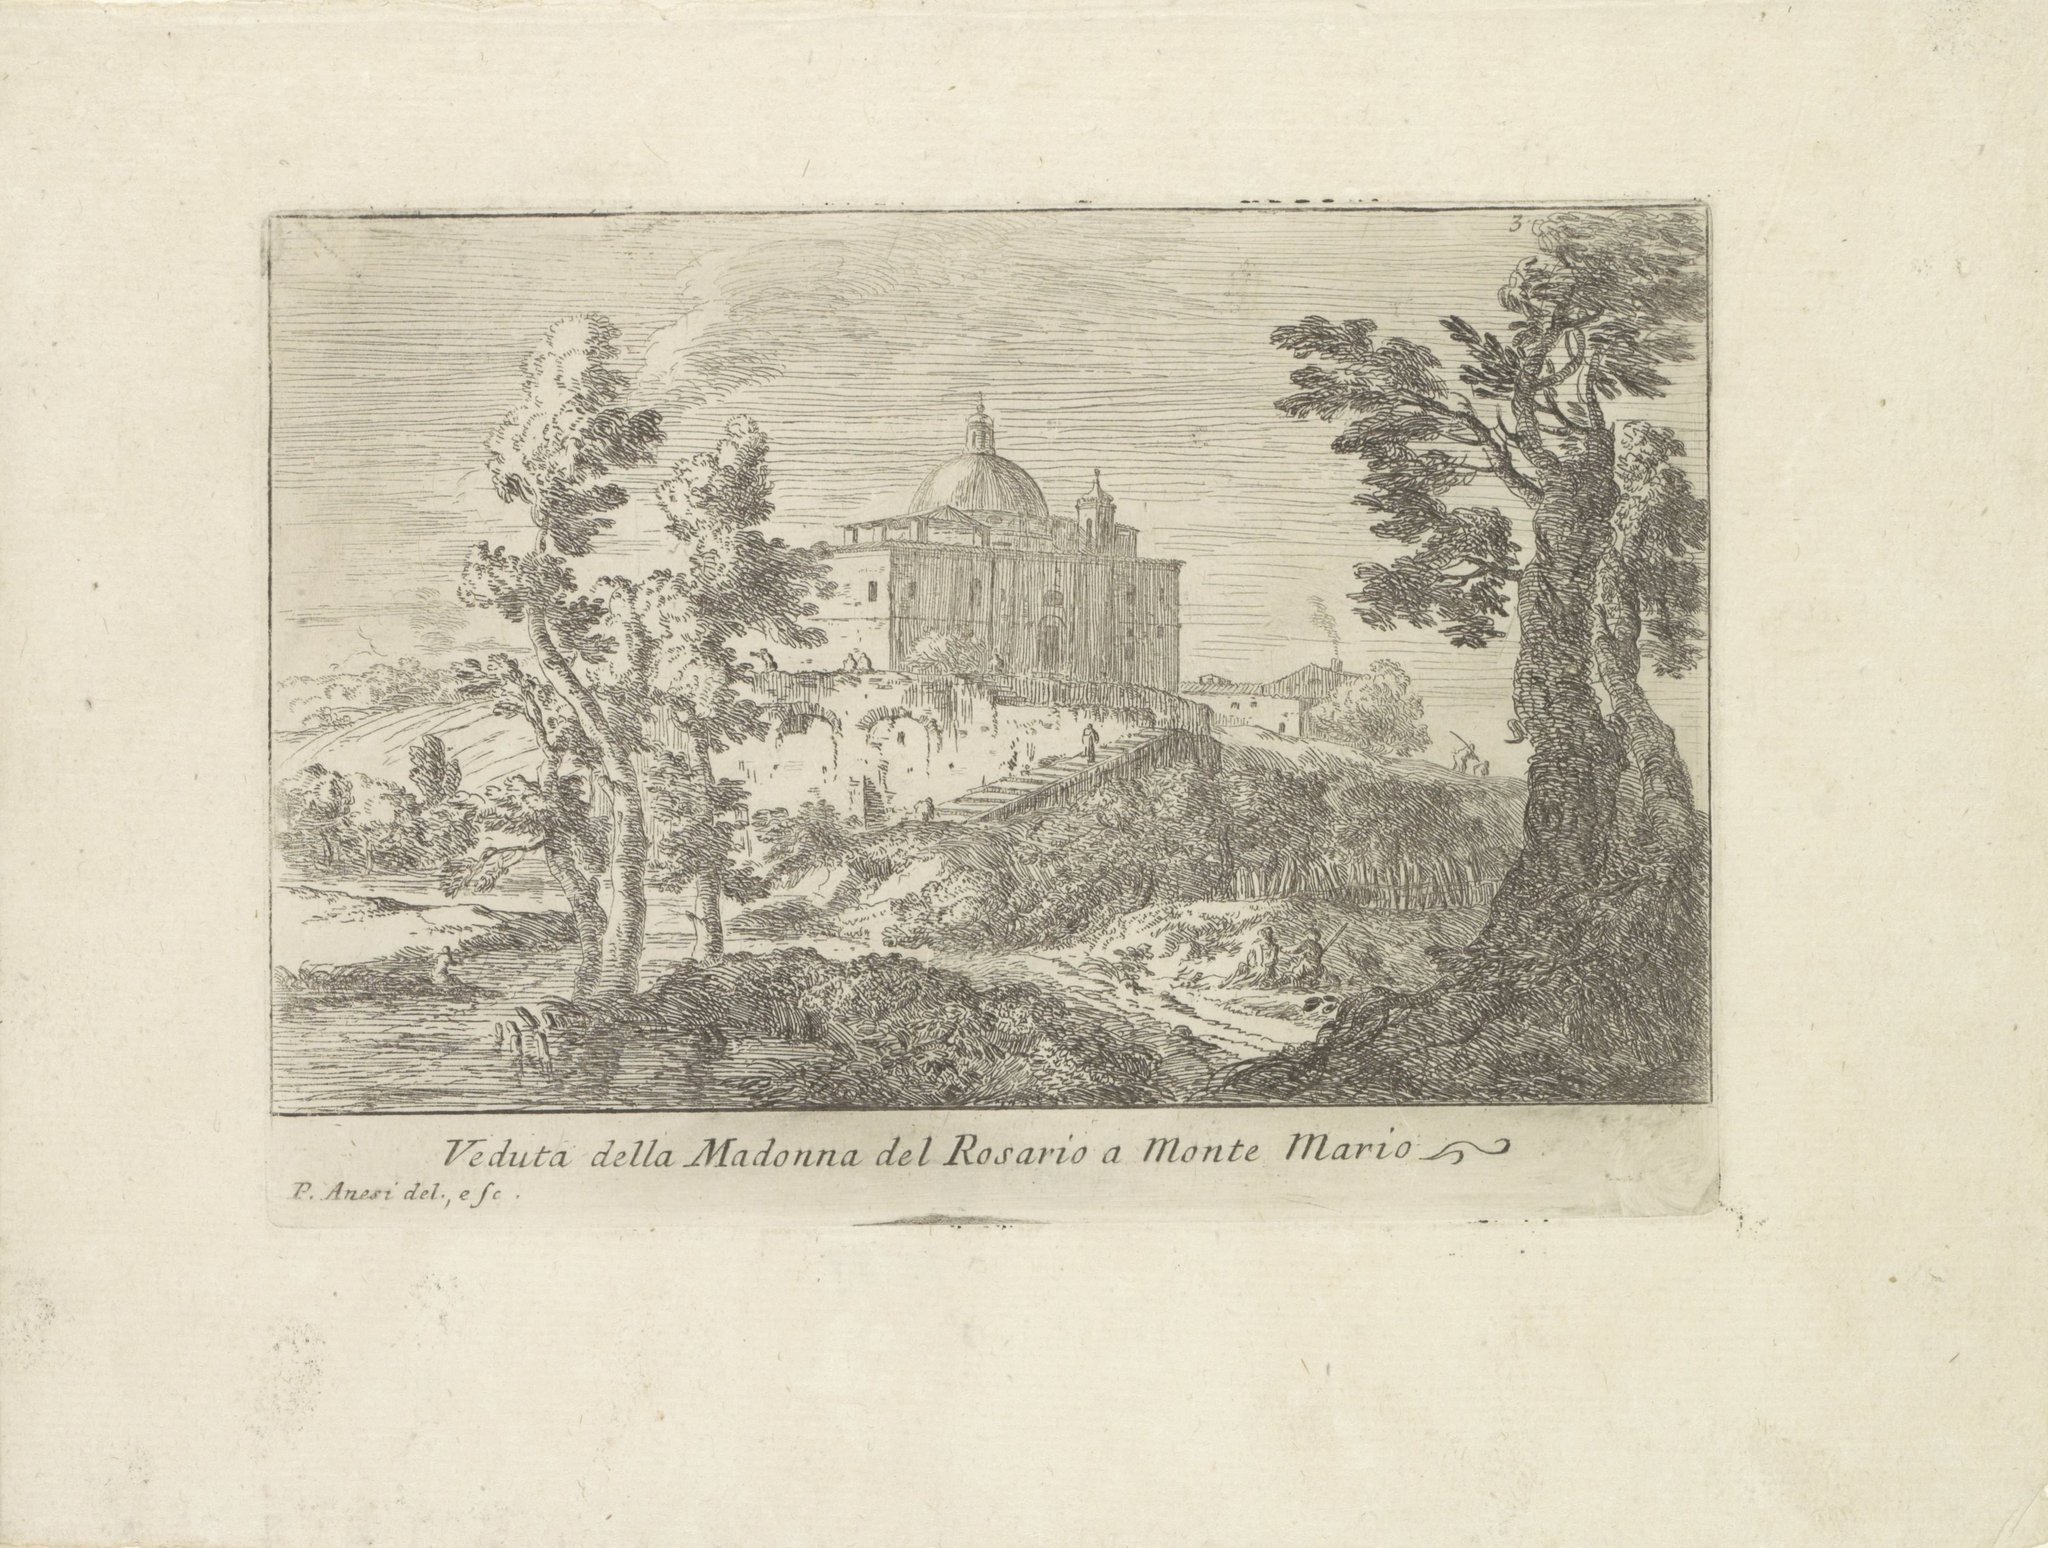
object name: print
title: Varie Vedute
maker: paolo anesi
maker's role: print maker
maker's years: 1700-1761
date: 1725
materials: paper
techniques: etching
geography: rome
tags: city-view, and landscape with man-made constructions, church (exterior), rome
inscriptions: collector's mark: Lugt 2228, collector's mark: Lugt 2760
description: Landschap met de Chiesa della Madonna del Rosario op de Monte Mario in Rome. Onder de voorstelling de titel. Genummerd rechtsboven: 3.